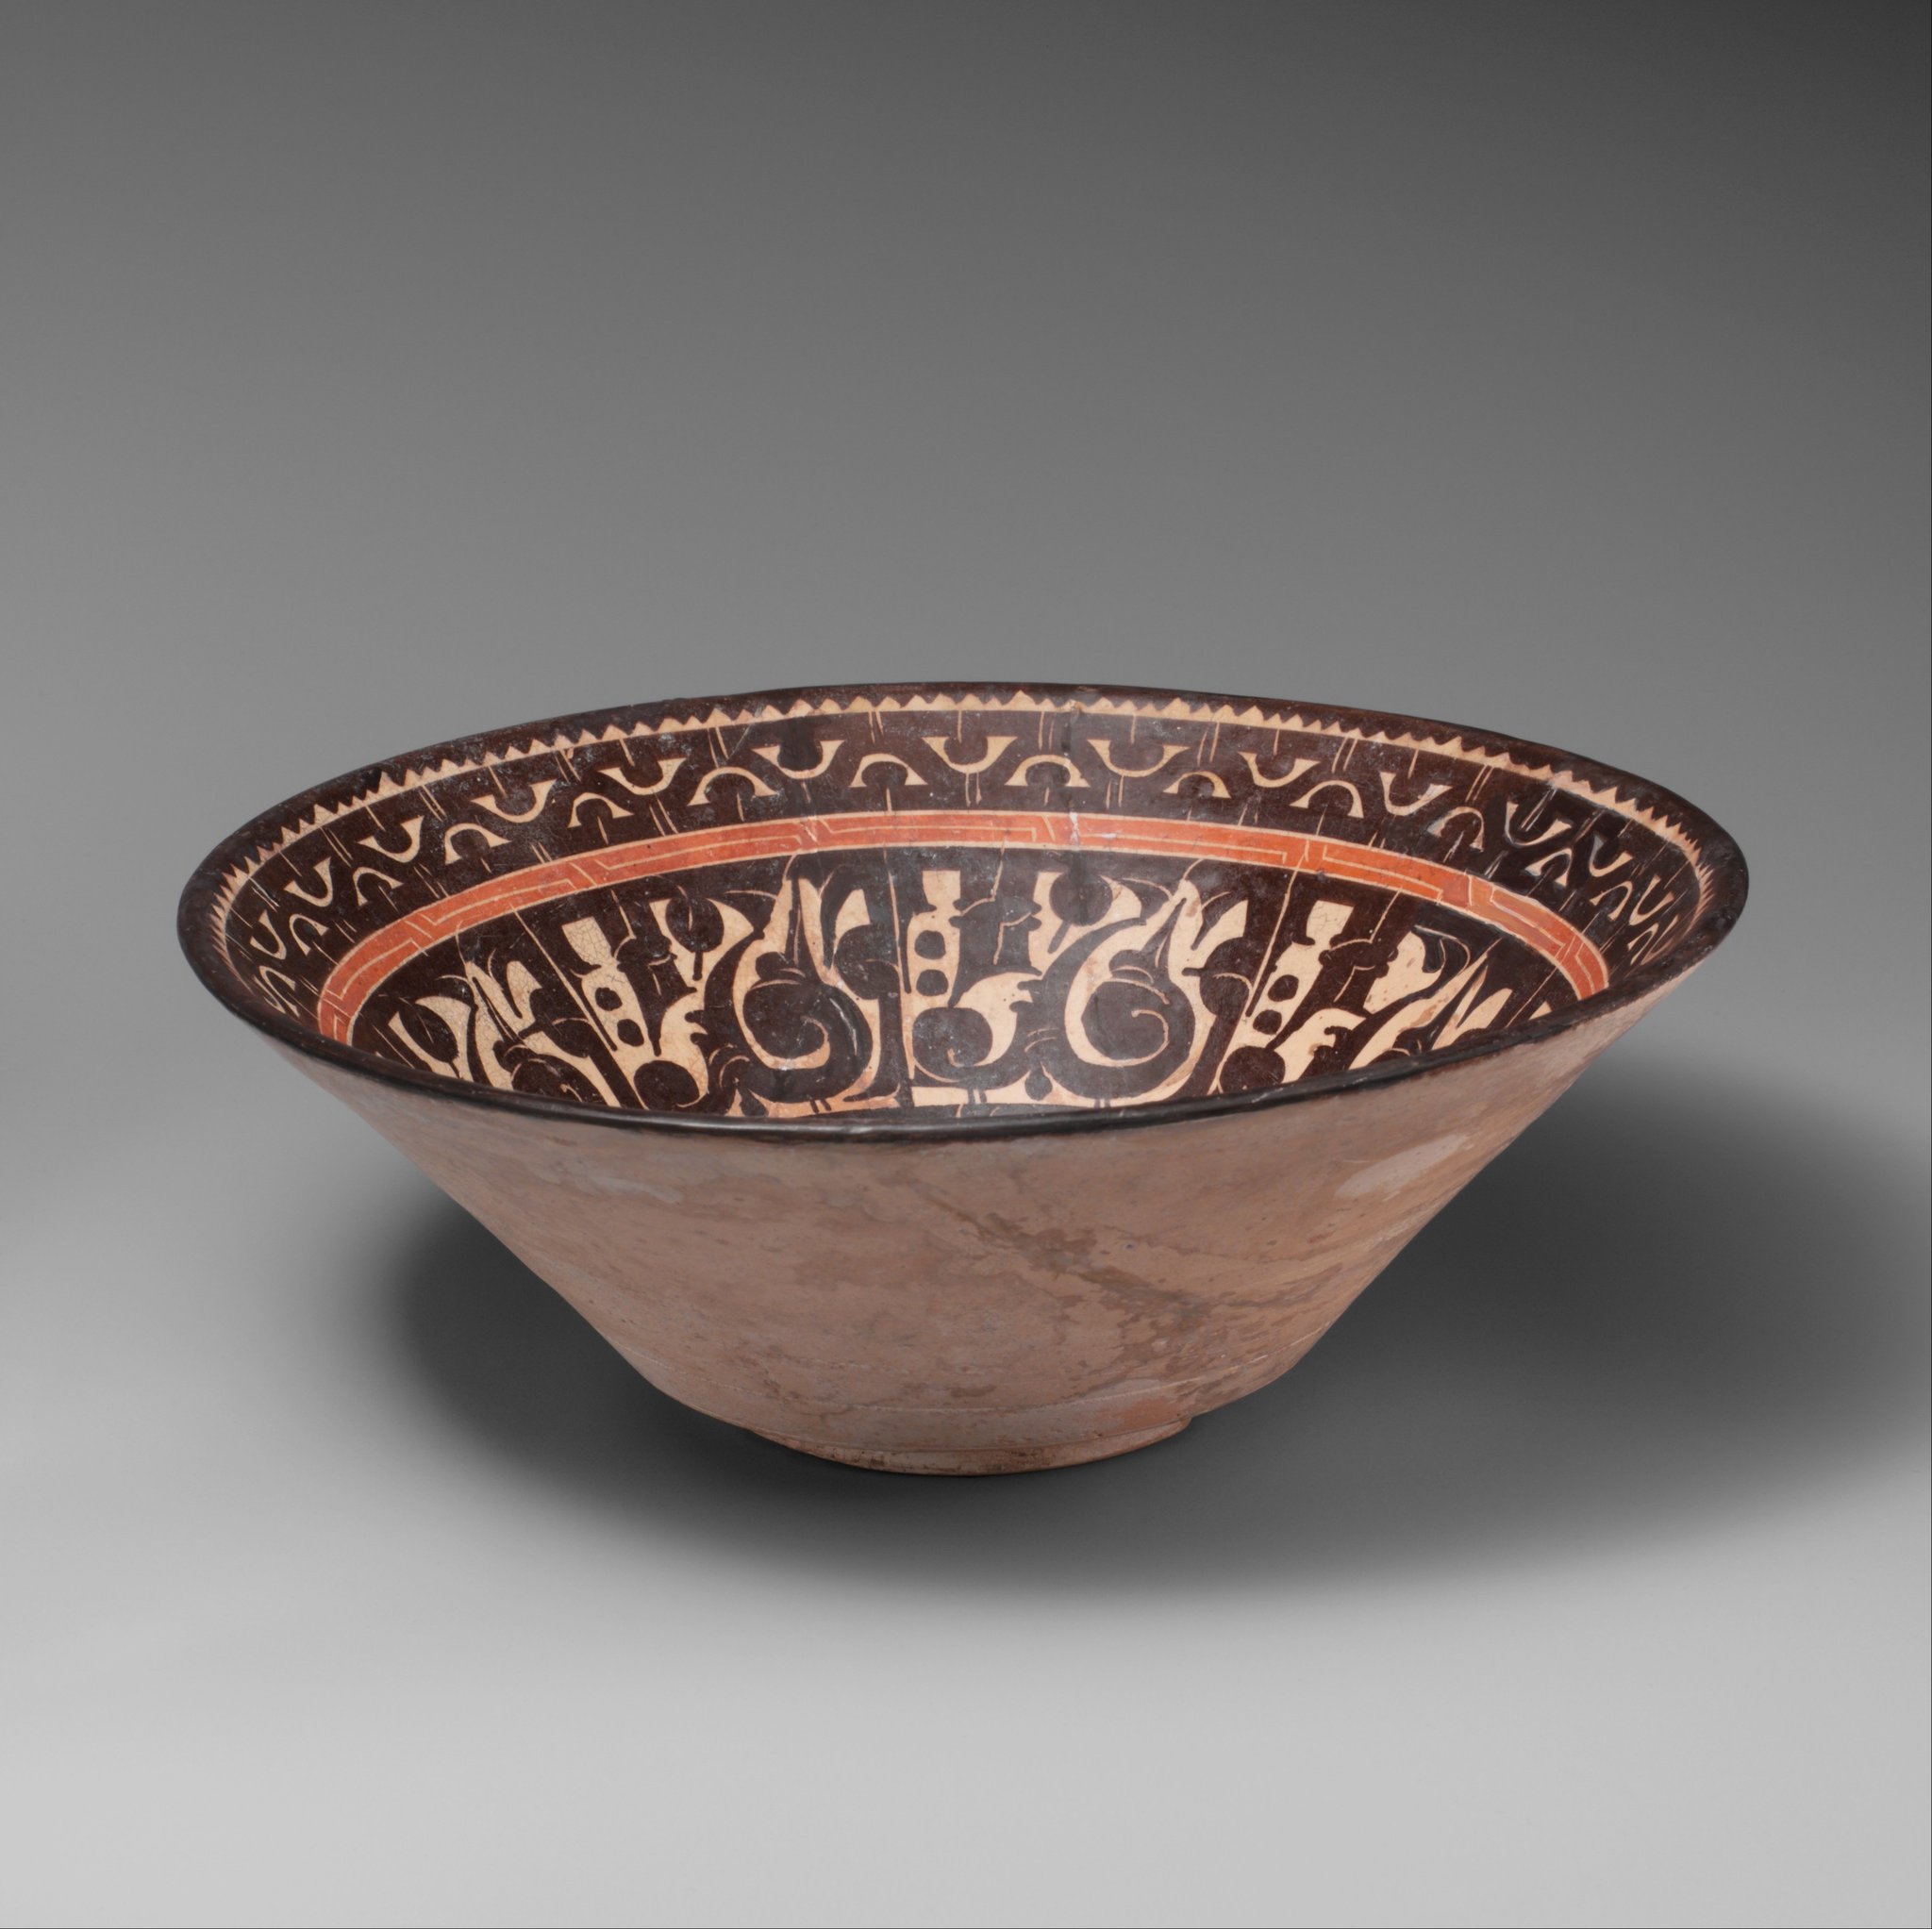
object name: bowl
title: Bowl with Pseudo-Inscriptional Design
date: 901-1000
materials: earthenware, glaze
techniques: polychrome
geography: uzbekistan